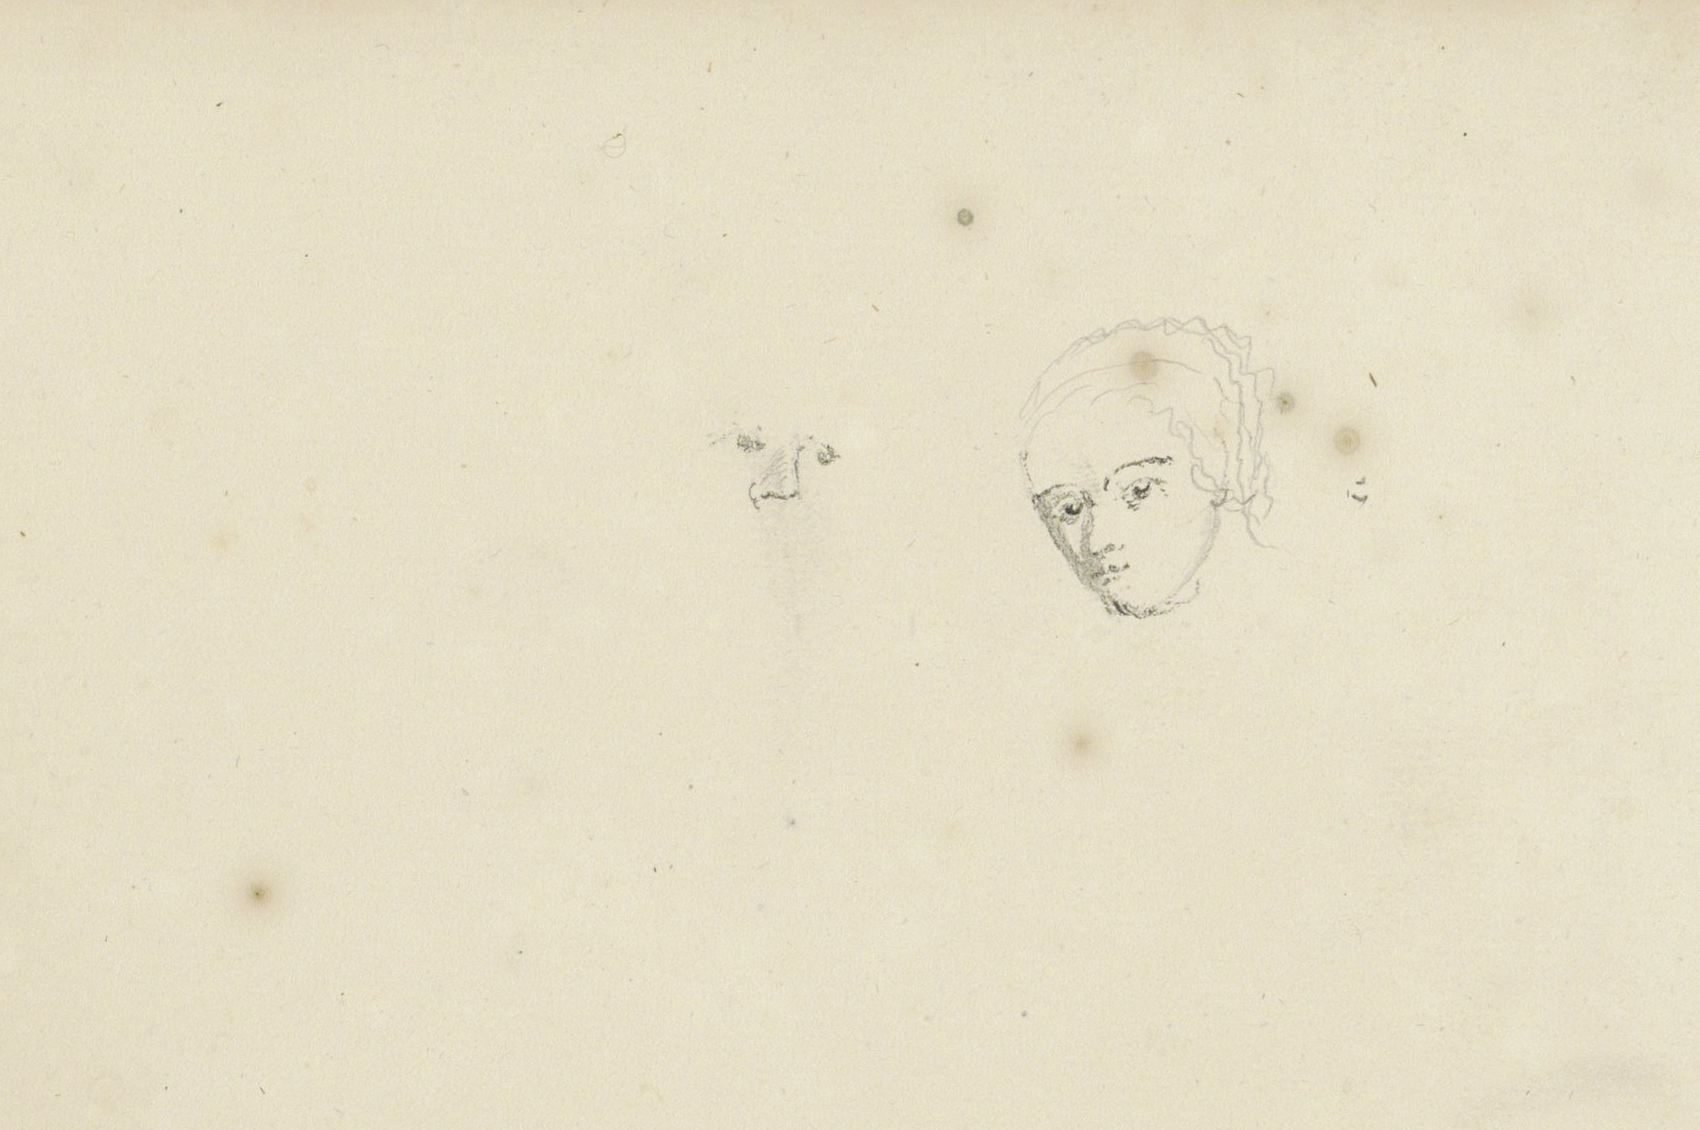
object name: sketchbook leaf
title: Kop van een vrouw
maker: abraham de haen (ii)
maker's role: draughtsman, print maker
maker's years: 1707-1748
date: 1717-1748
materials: paper, pencil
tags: head (human)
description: Tevens een studie van twee ogen en een neus. Blad 23 verso uit een schetsboek met 21 bladen.